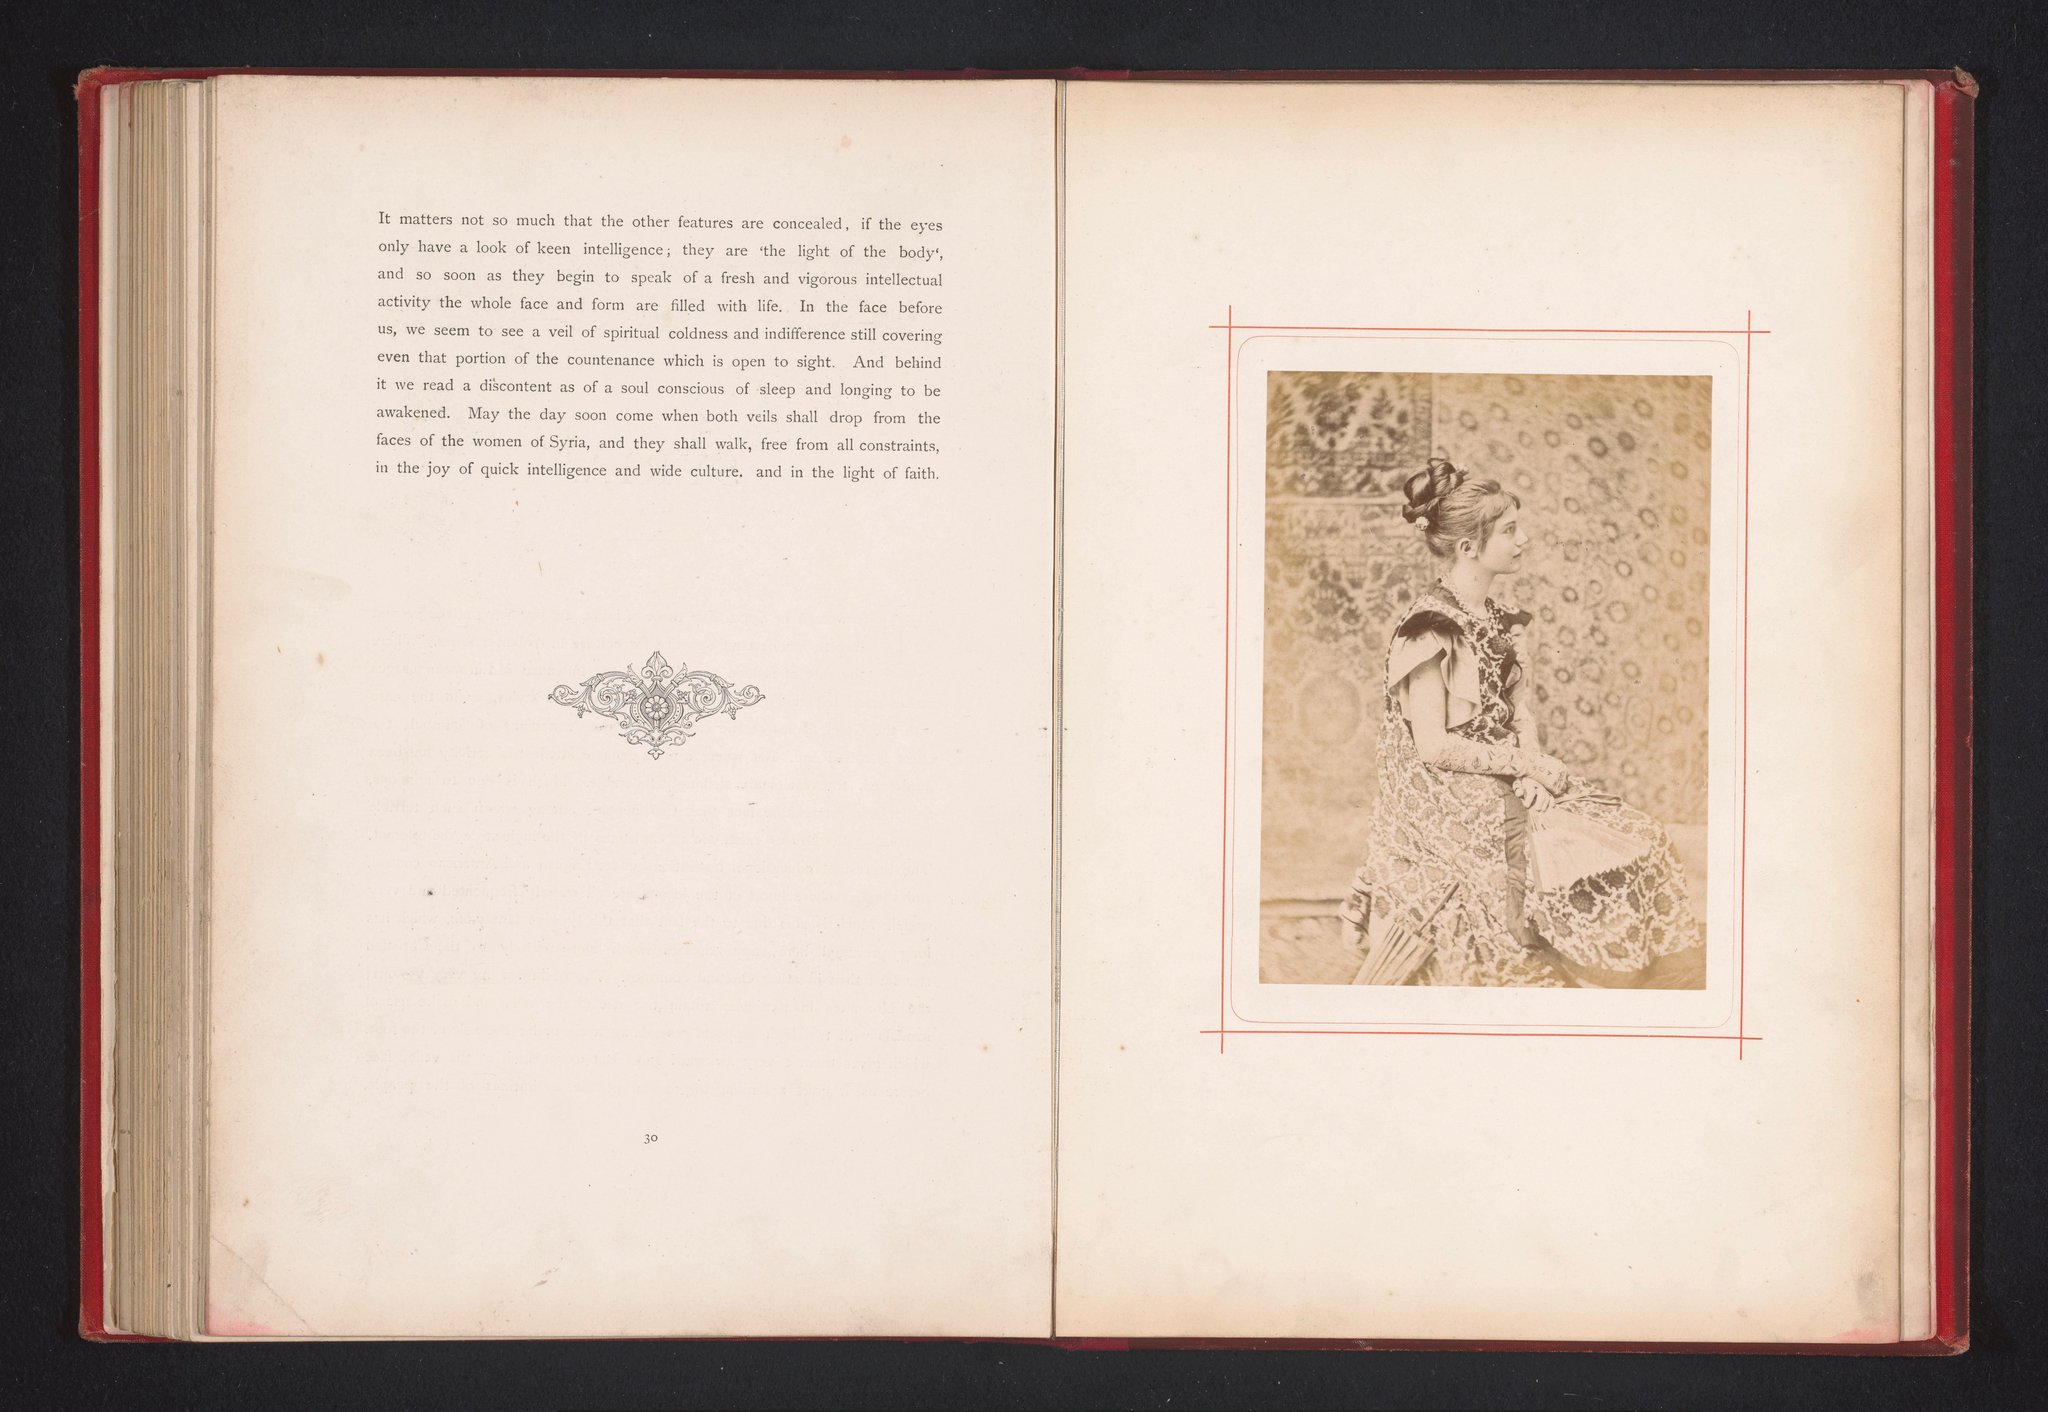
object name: page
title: Portret van een onbekende vrouw in klederdracht uit China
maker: Anonymous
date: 1876-1886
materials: photographic support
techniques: albumen print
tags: folk costume, regional costume, anonymous historical person portrayed - bb - woman